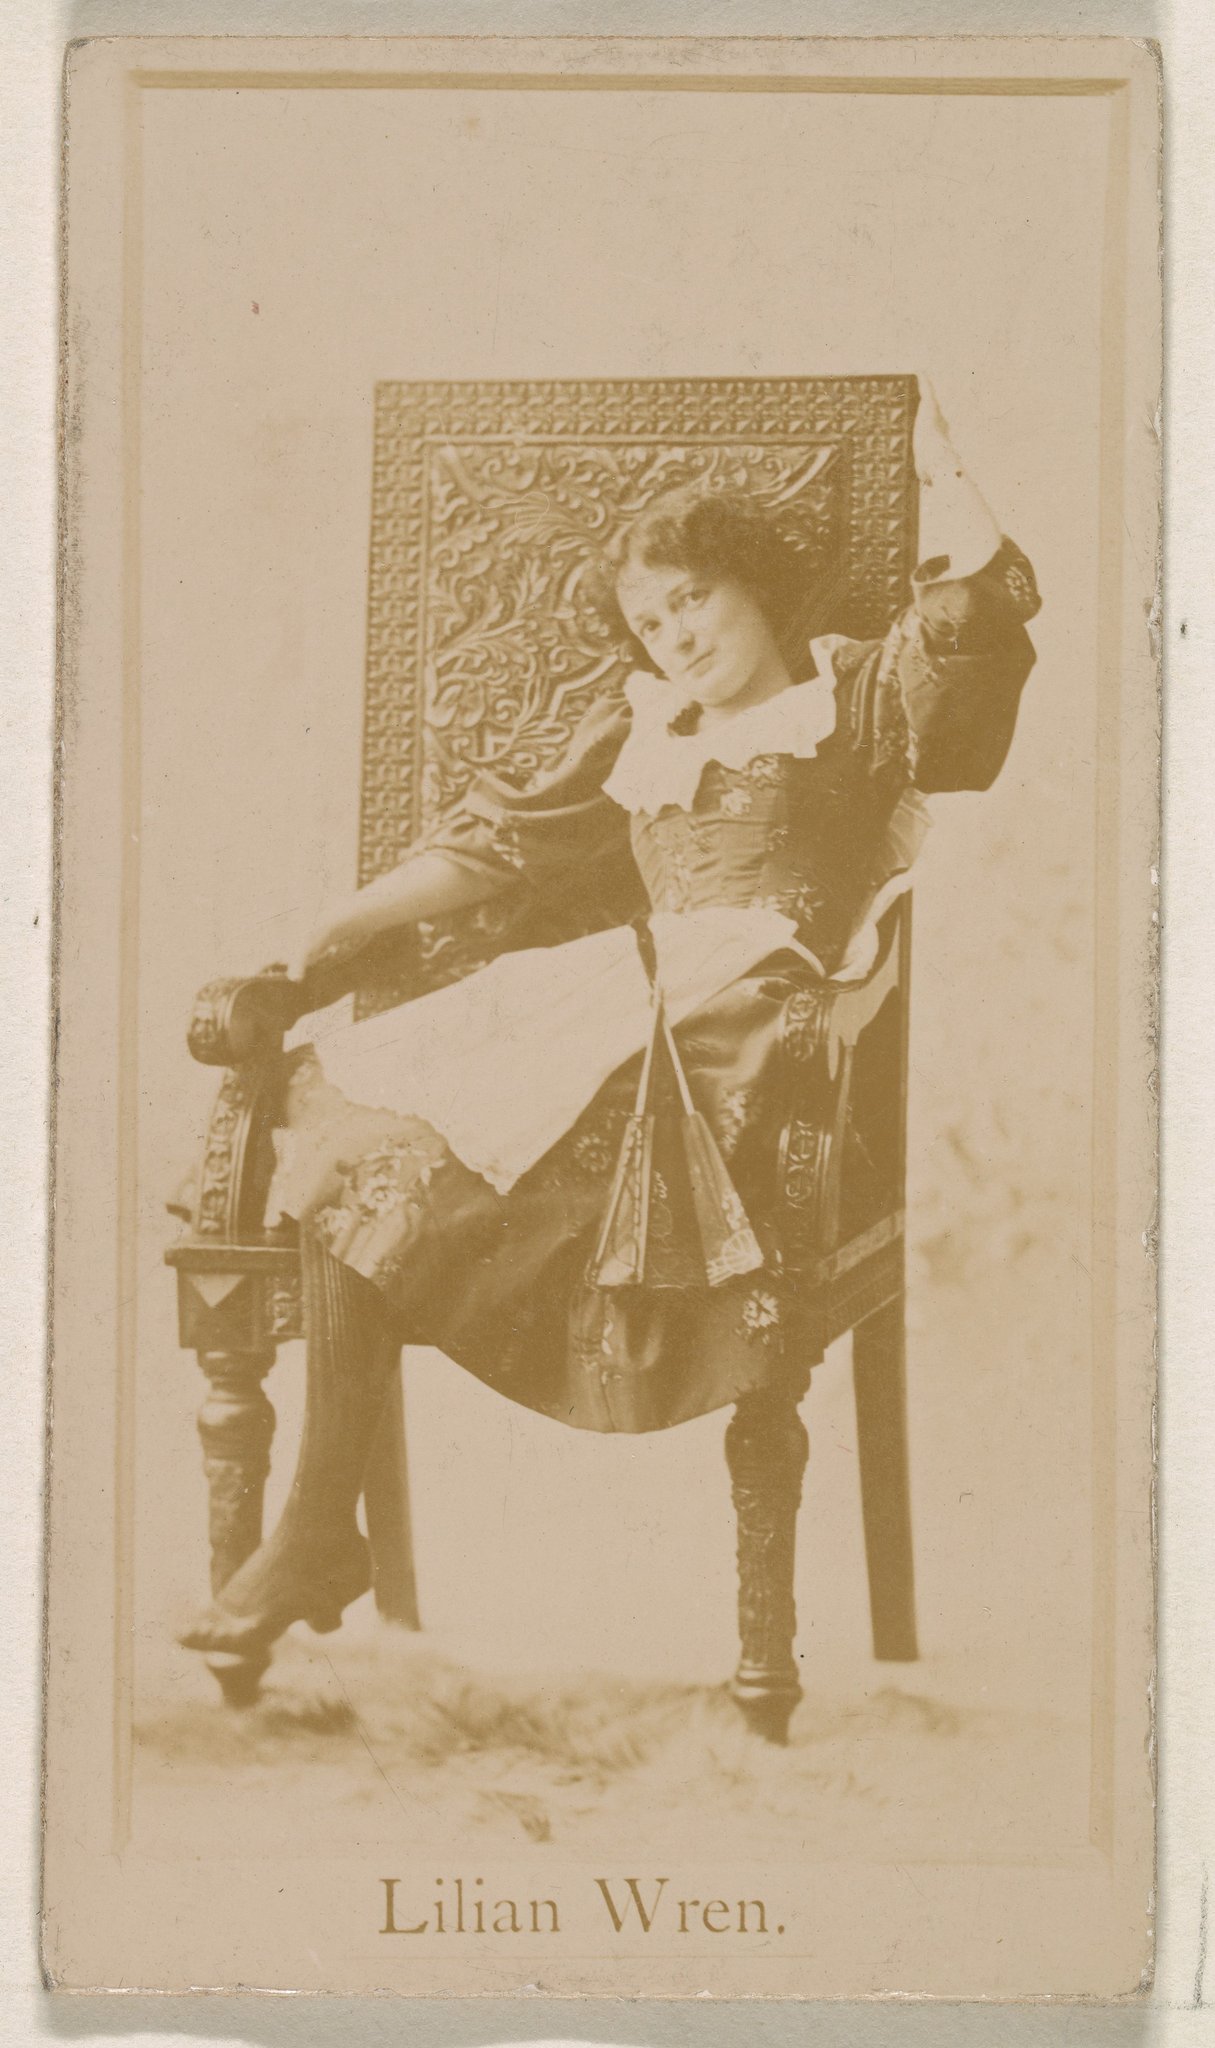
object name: photograph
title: Lilian Wren, from the Actresses series (N245) issued by Kinney Brothers to promote Sweet Caporal Cigarettes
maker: kinney brothers tobacco company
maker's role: publisher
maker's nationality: american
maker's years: 1869-2011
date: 1890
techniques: albumen silver print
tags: portraits,women,actresses